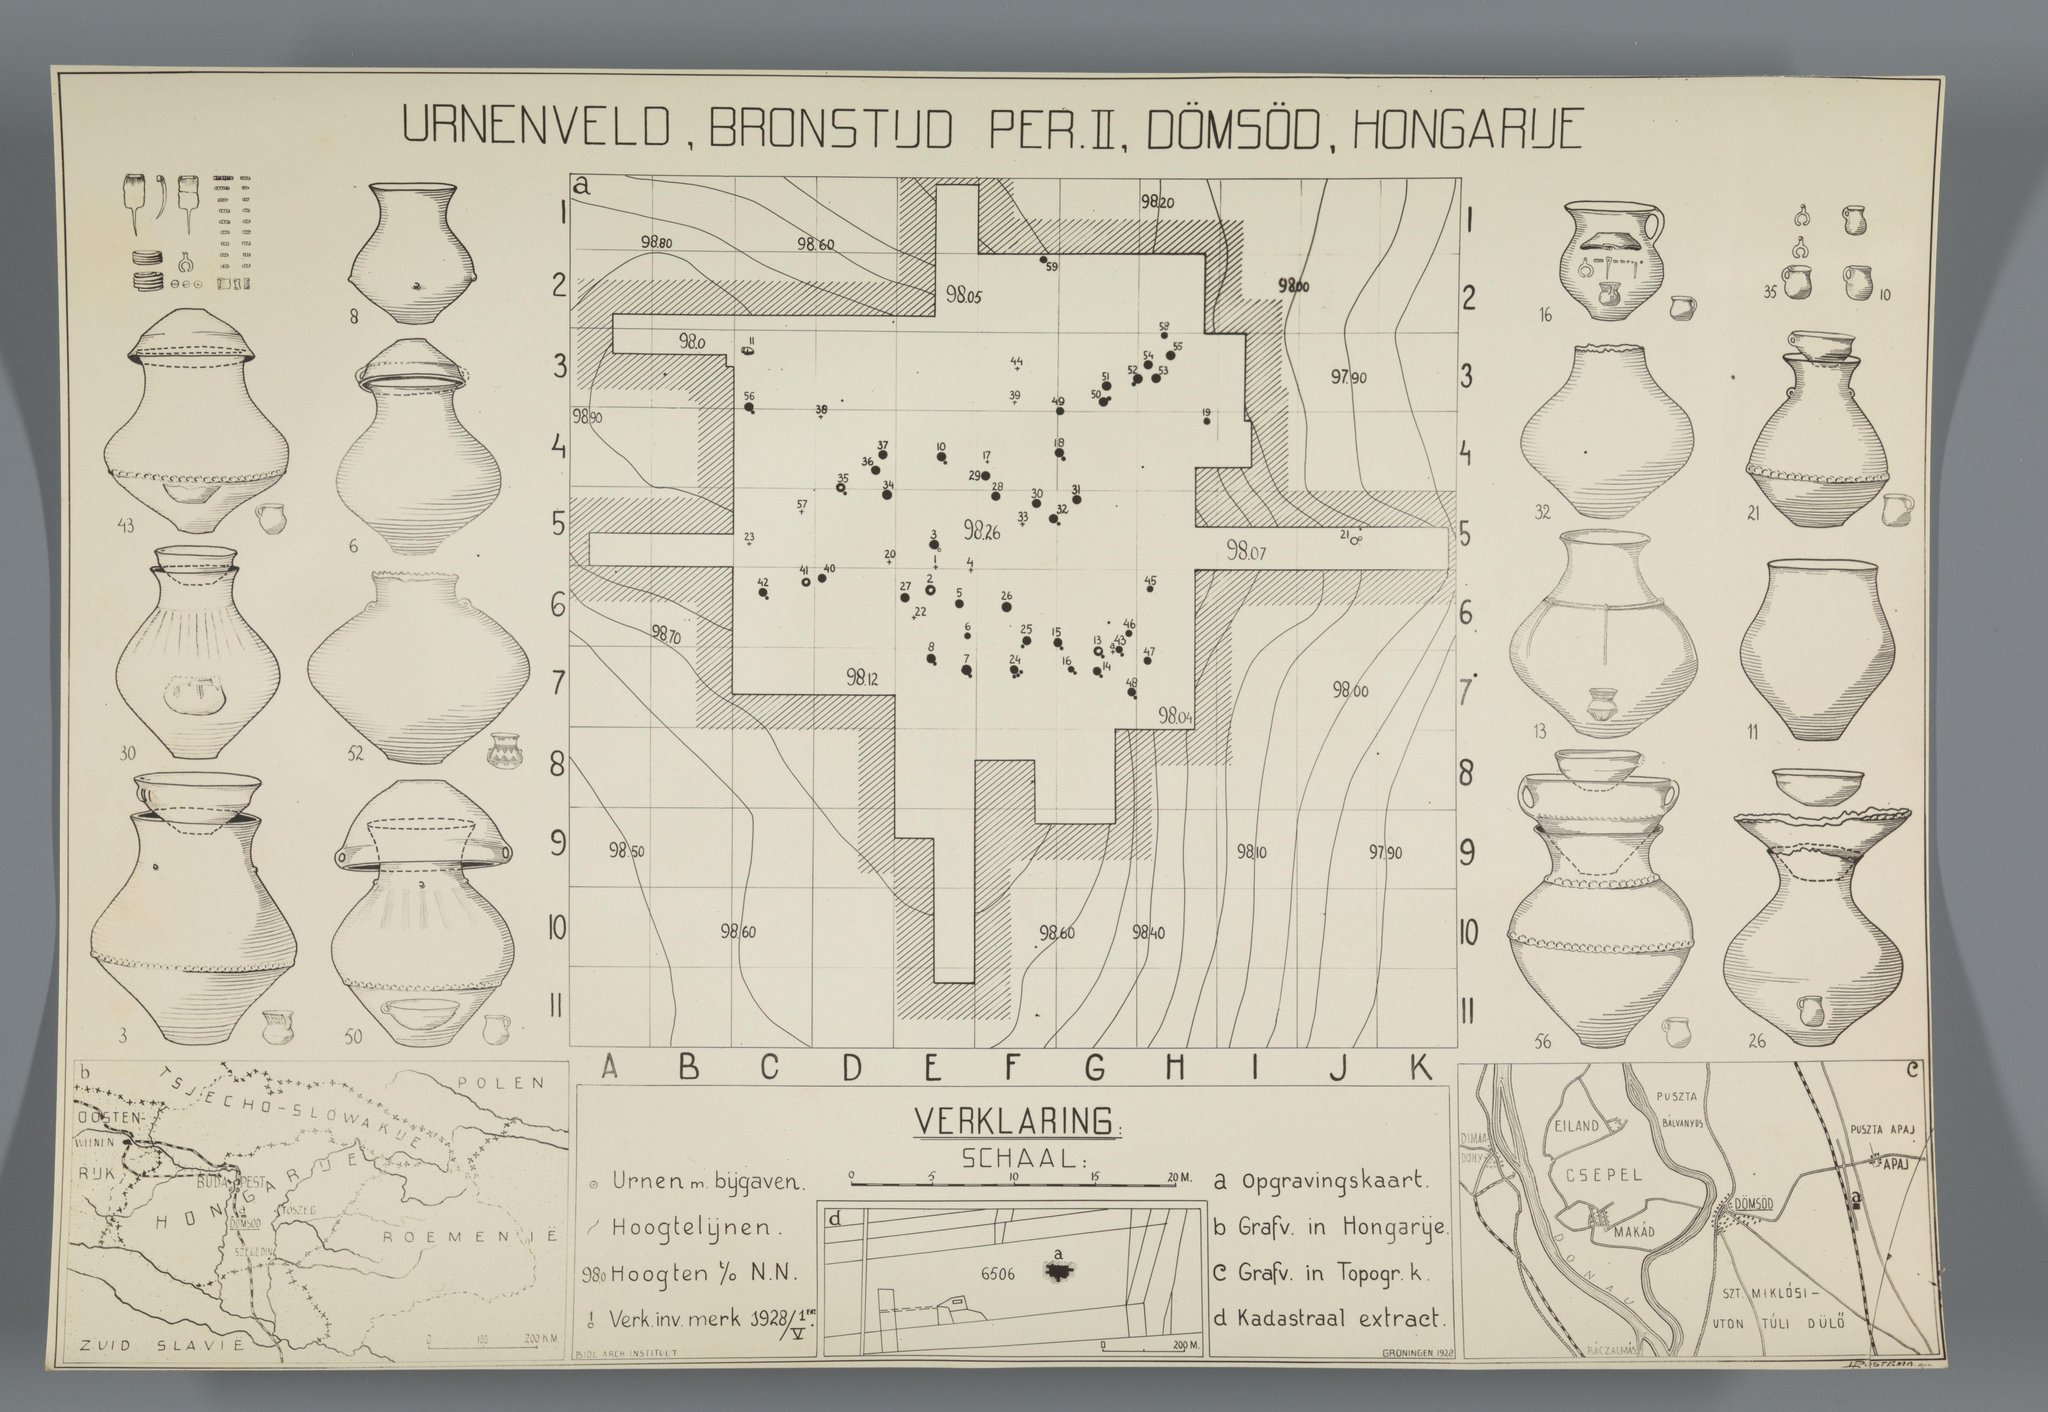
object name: photograph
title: Urnenveld Bronstijd per. II, Dömsöd, Hongarije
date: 1928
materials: paper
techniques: gelatin silver print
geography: groningen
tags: urn, excavation ~ archaeology